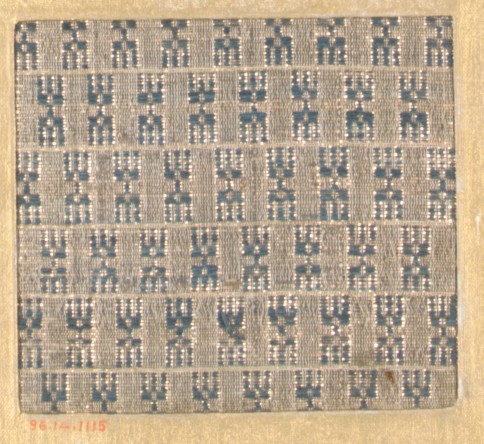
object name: piece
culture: japanese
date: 1701-1900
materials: silk